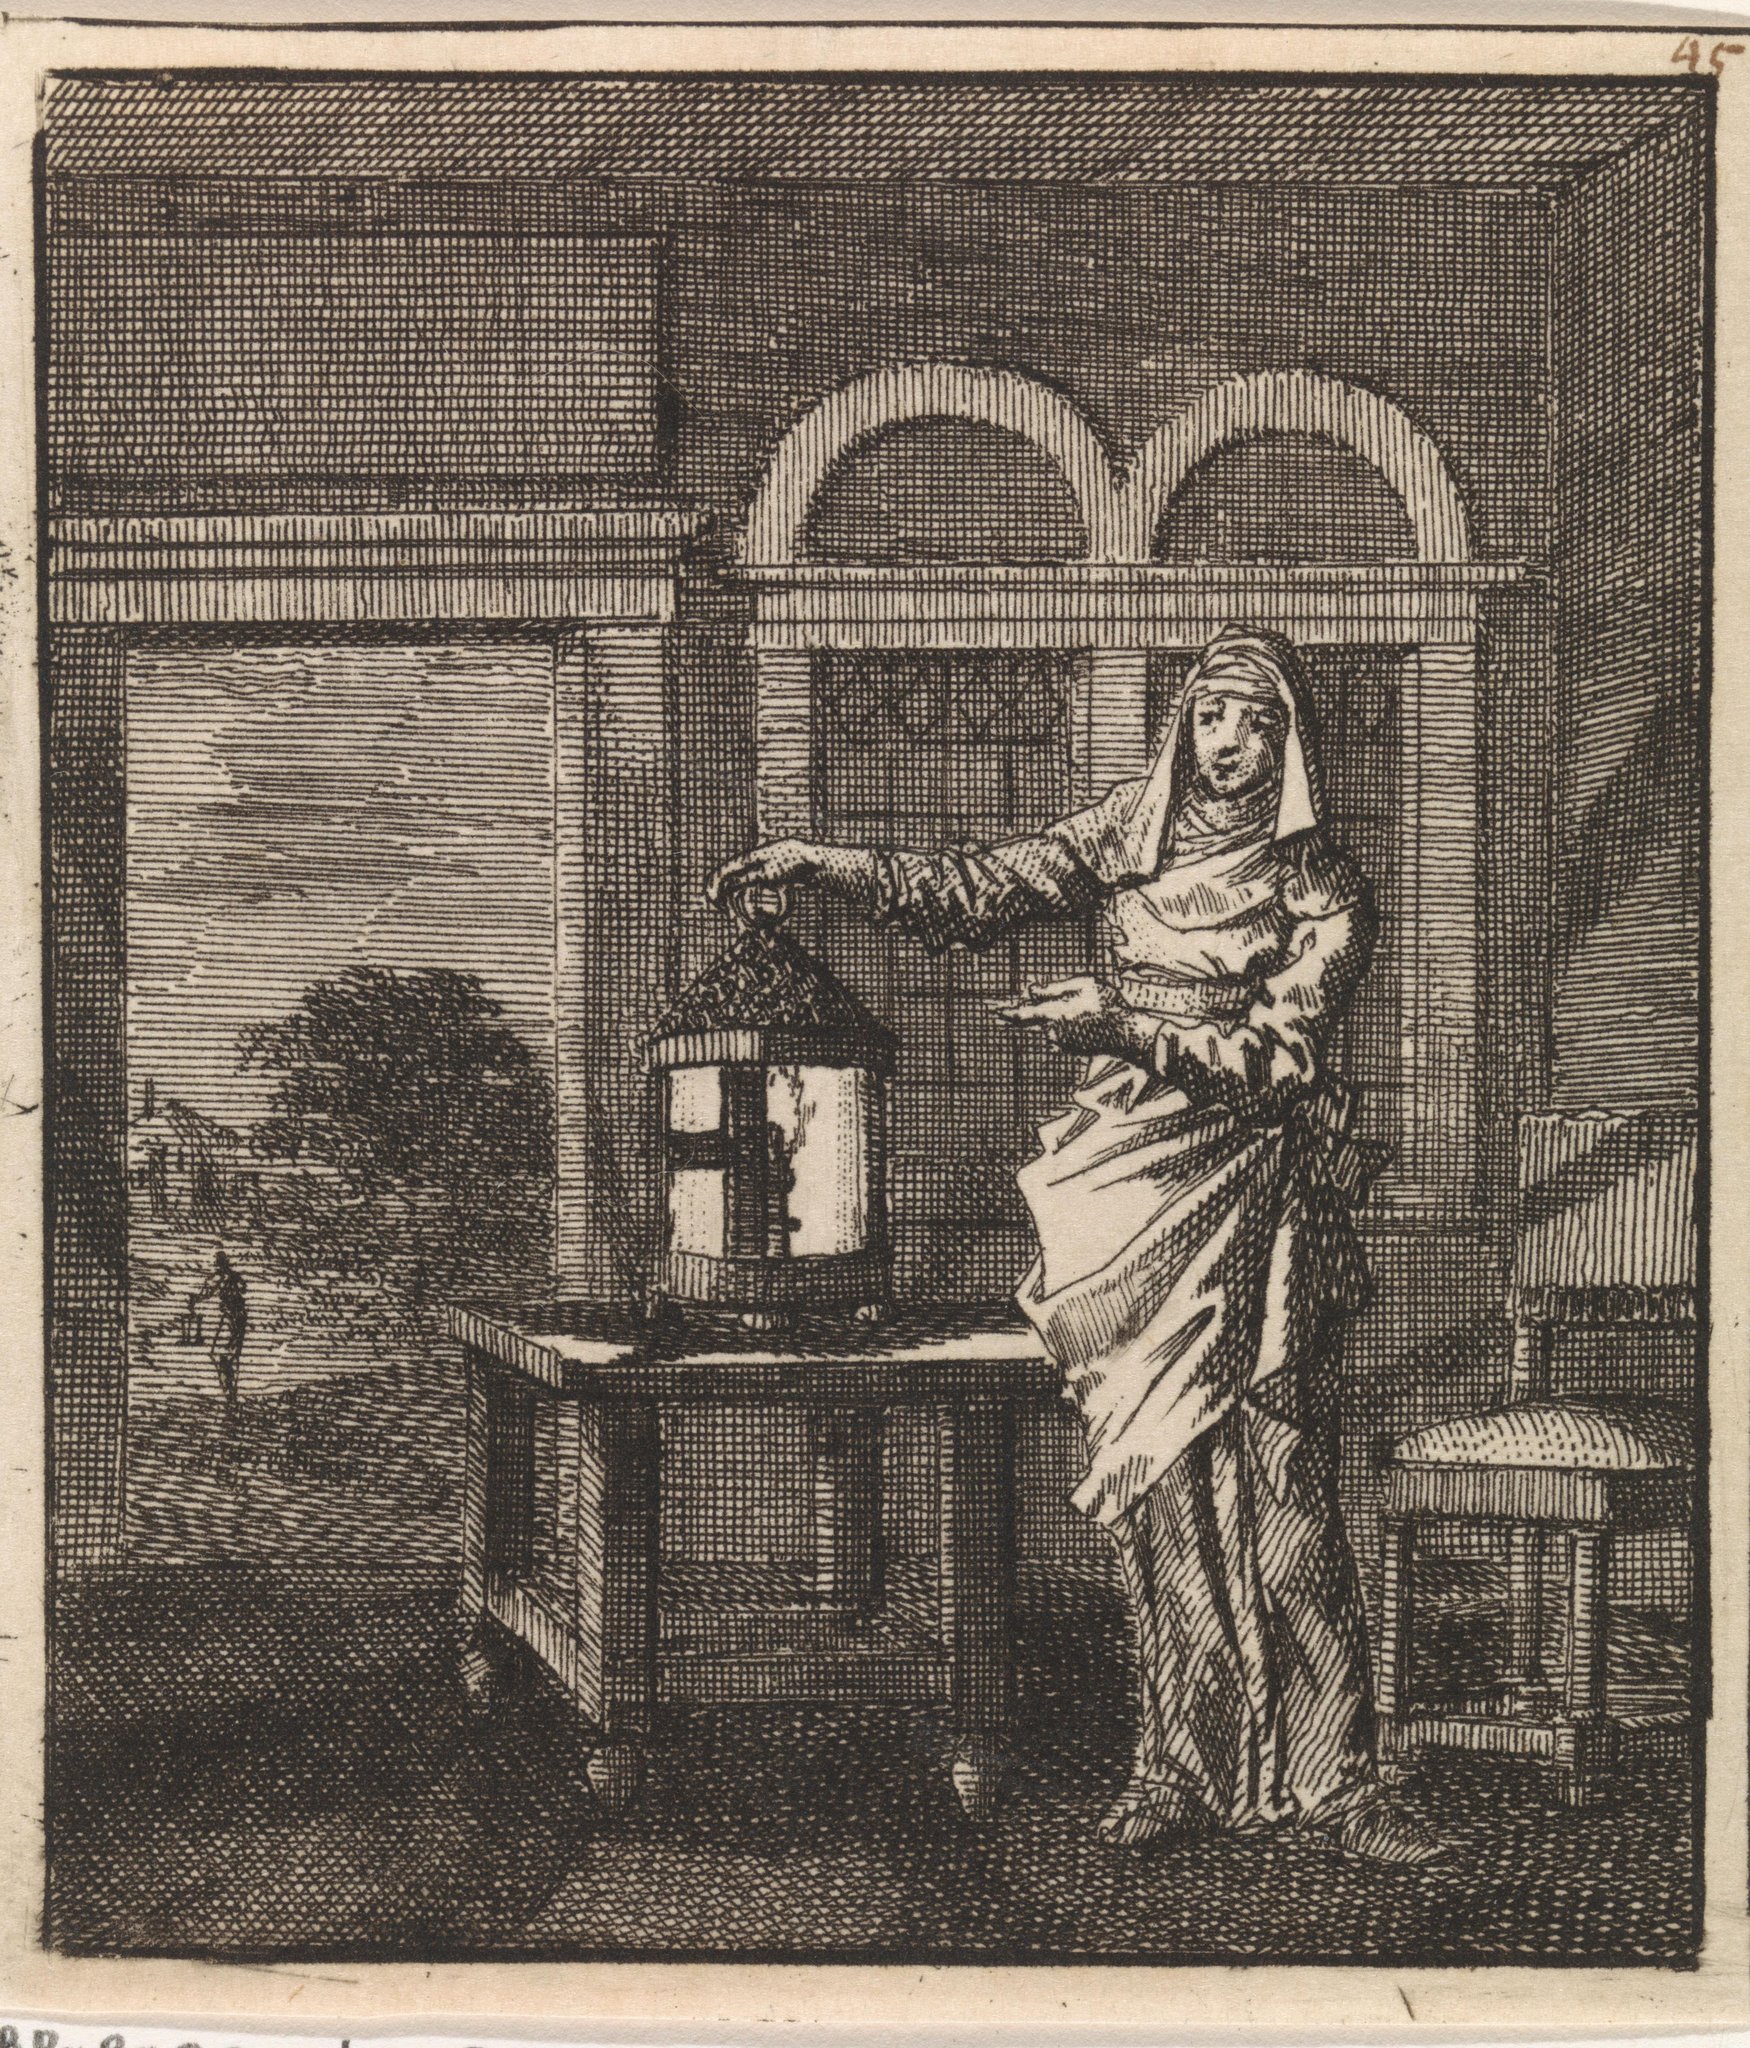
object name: print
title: Vrouw zet een brandende lantaarn op een tafel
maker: jan luyken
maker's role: draughtsman, print maker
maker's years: 1649-1712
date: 1711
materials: paper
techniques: etching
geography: amsterdam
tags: lantern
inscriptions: collector's mark: Lugt 2228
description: Proefdruk van illustratie voor: Luyken, Jan. Het leerzaam huisraad, vertoond in vyftig konstige figuuren, met godlyke spreuken en stichtelyke verzen: Pieter Arentsz. II (wed.) en Cornelis van der Sys, 1711, p. 156.